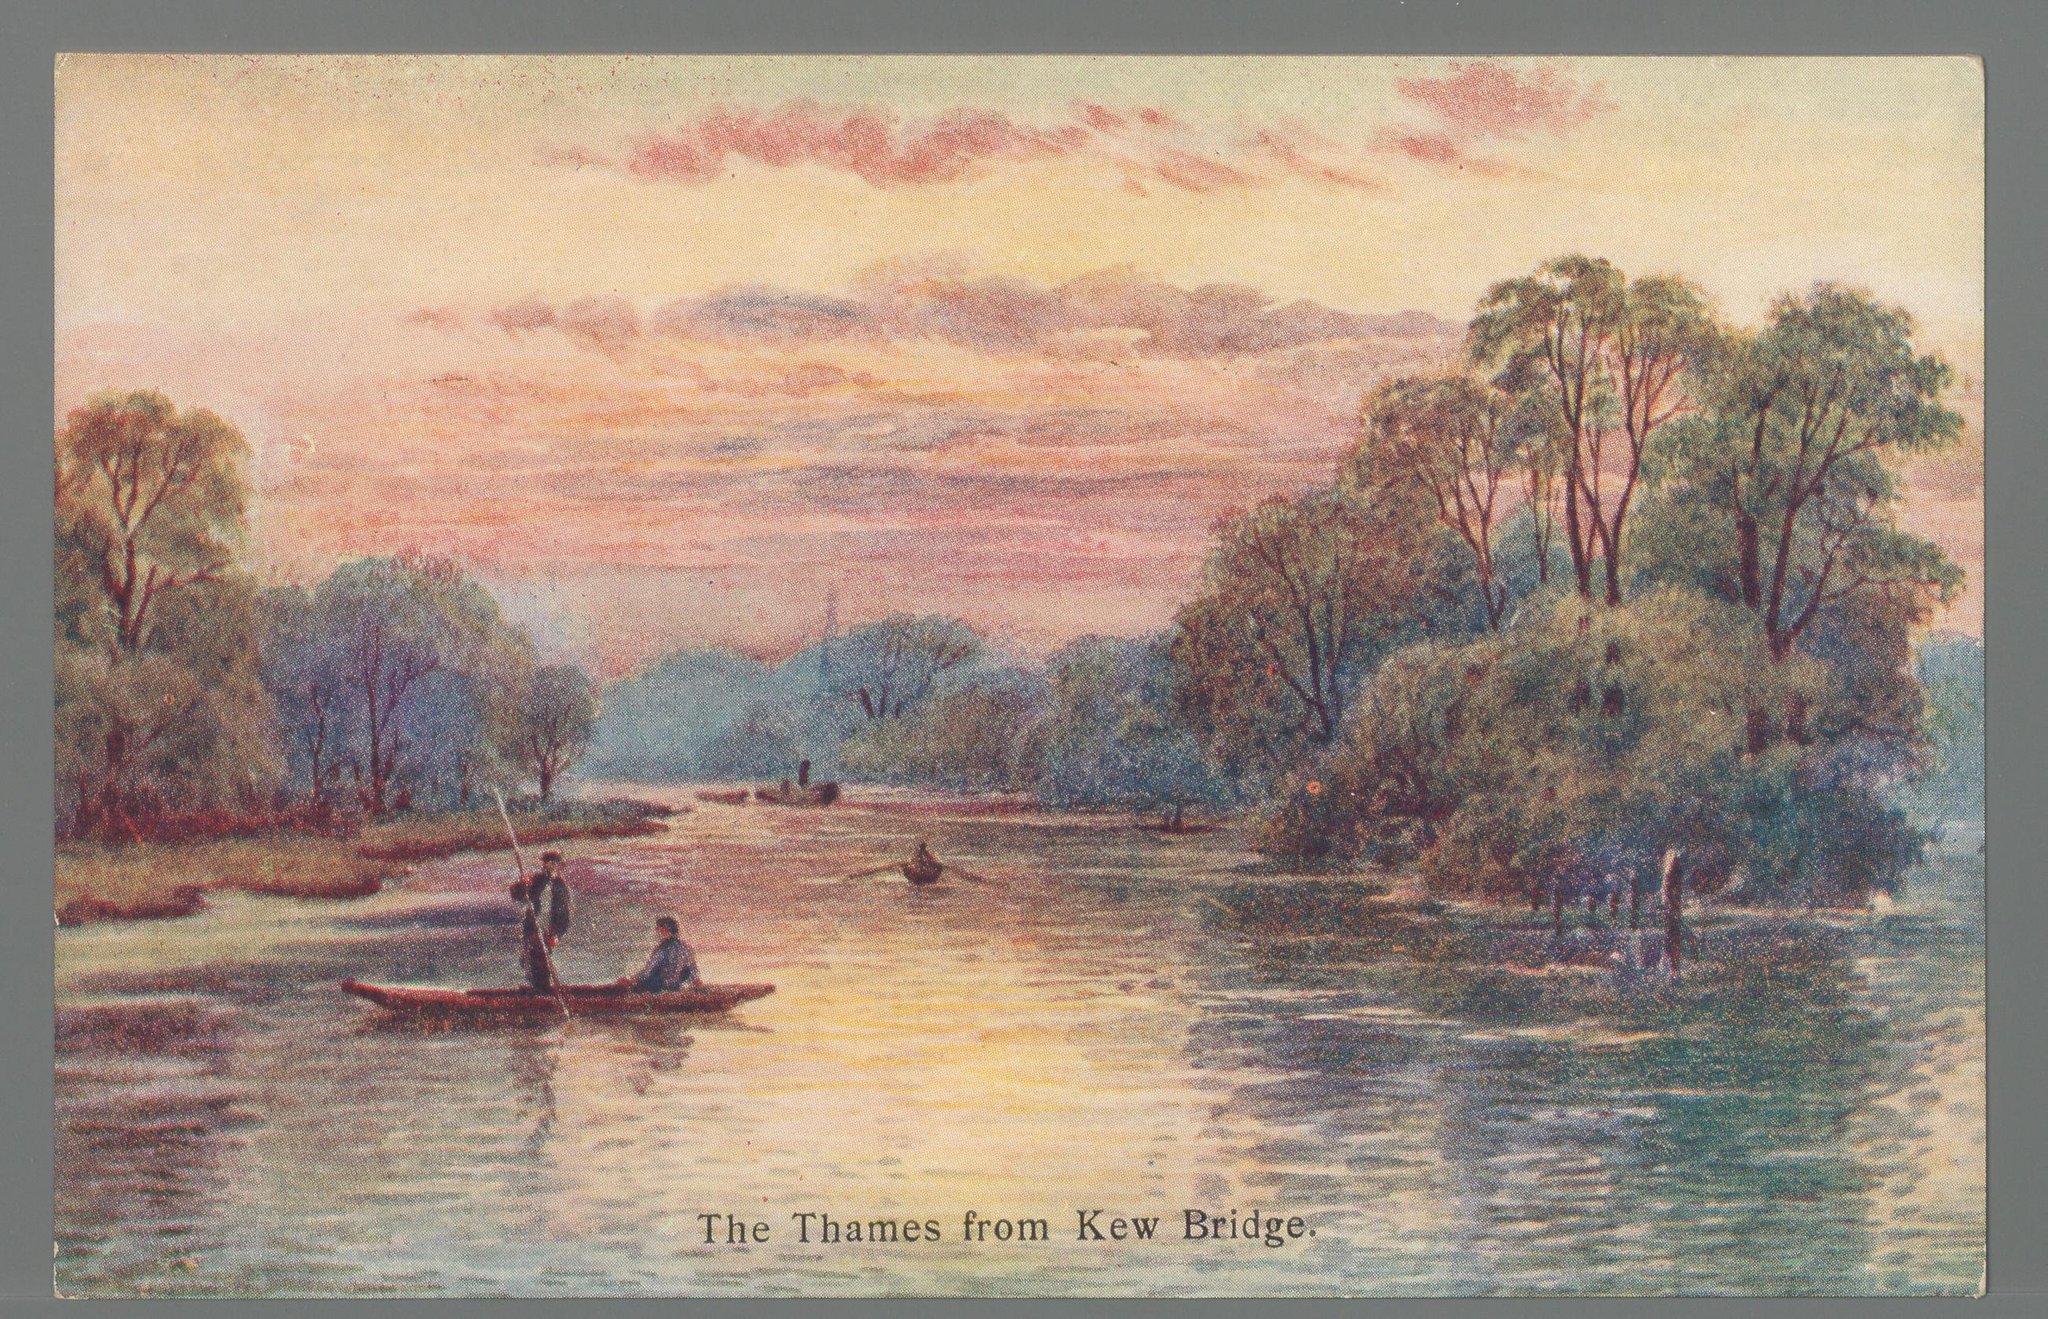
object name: reproduction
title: The Thames from Kew Bridge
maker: Anonymous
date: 1902-1940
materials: cardboard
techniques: color autotype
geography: london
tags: rowing-boat, canoe, etc., canals, waters (in city), thames